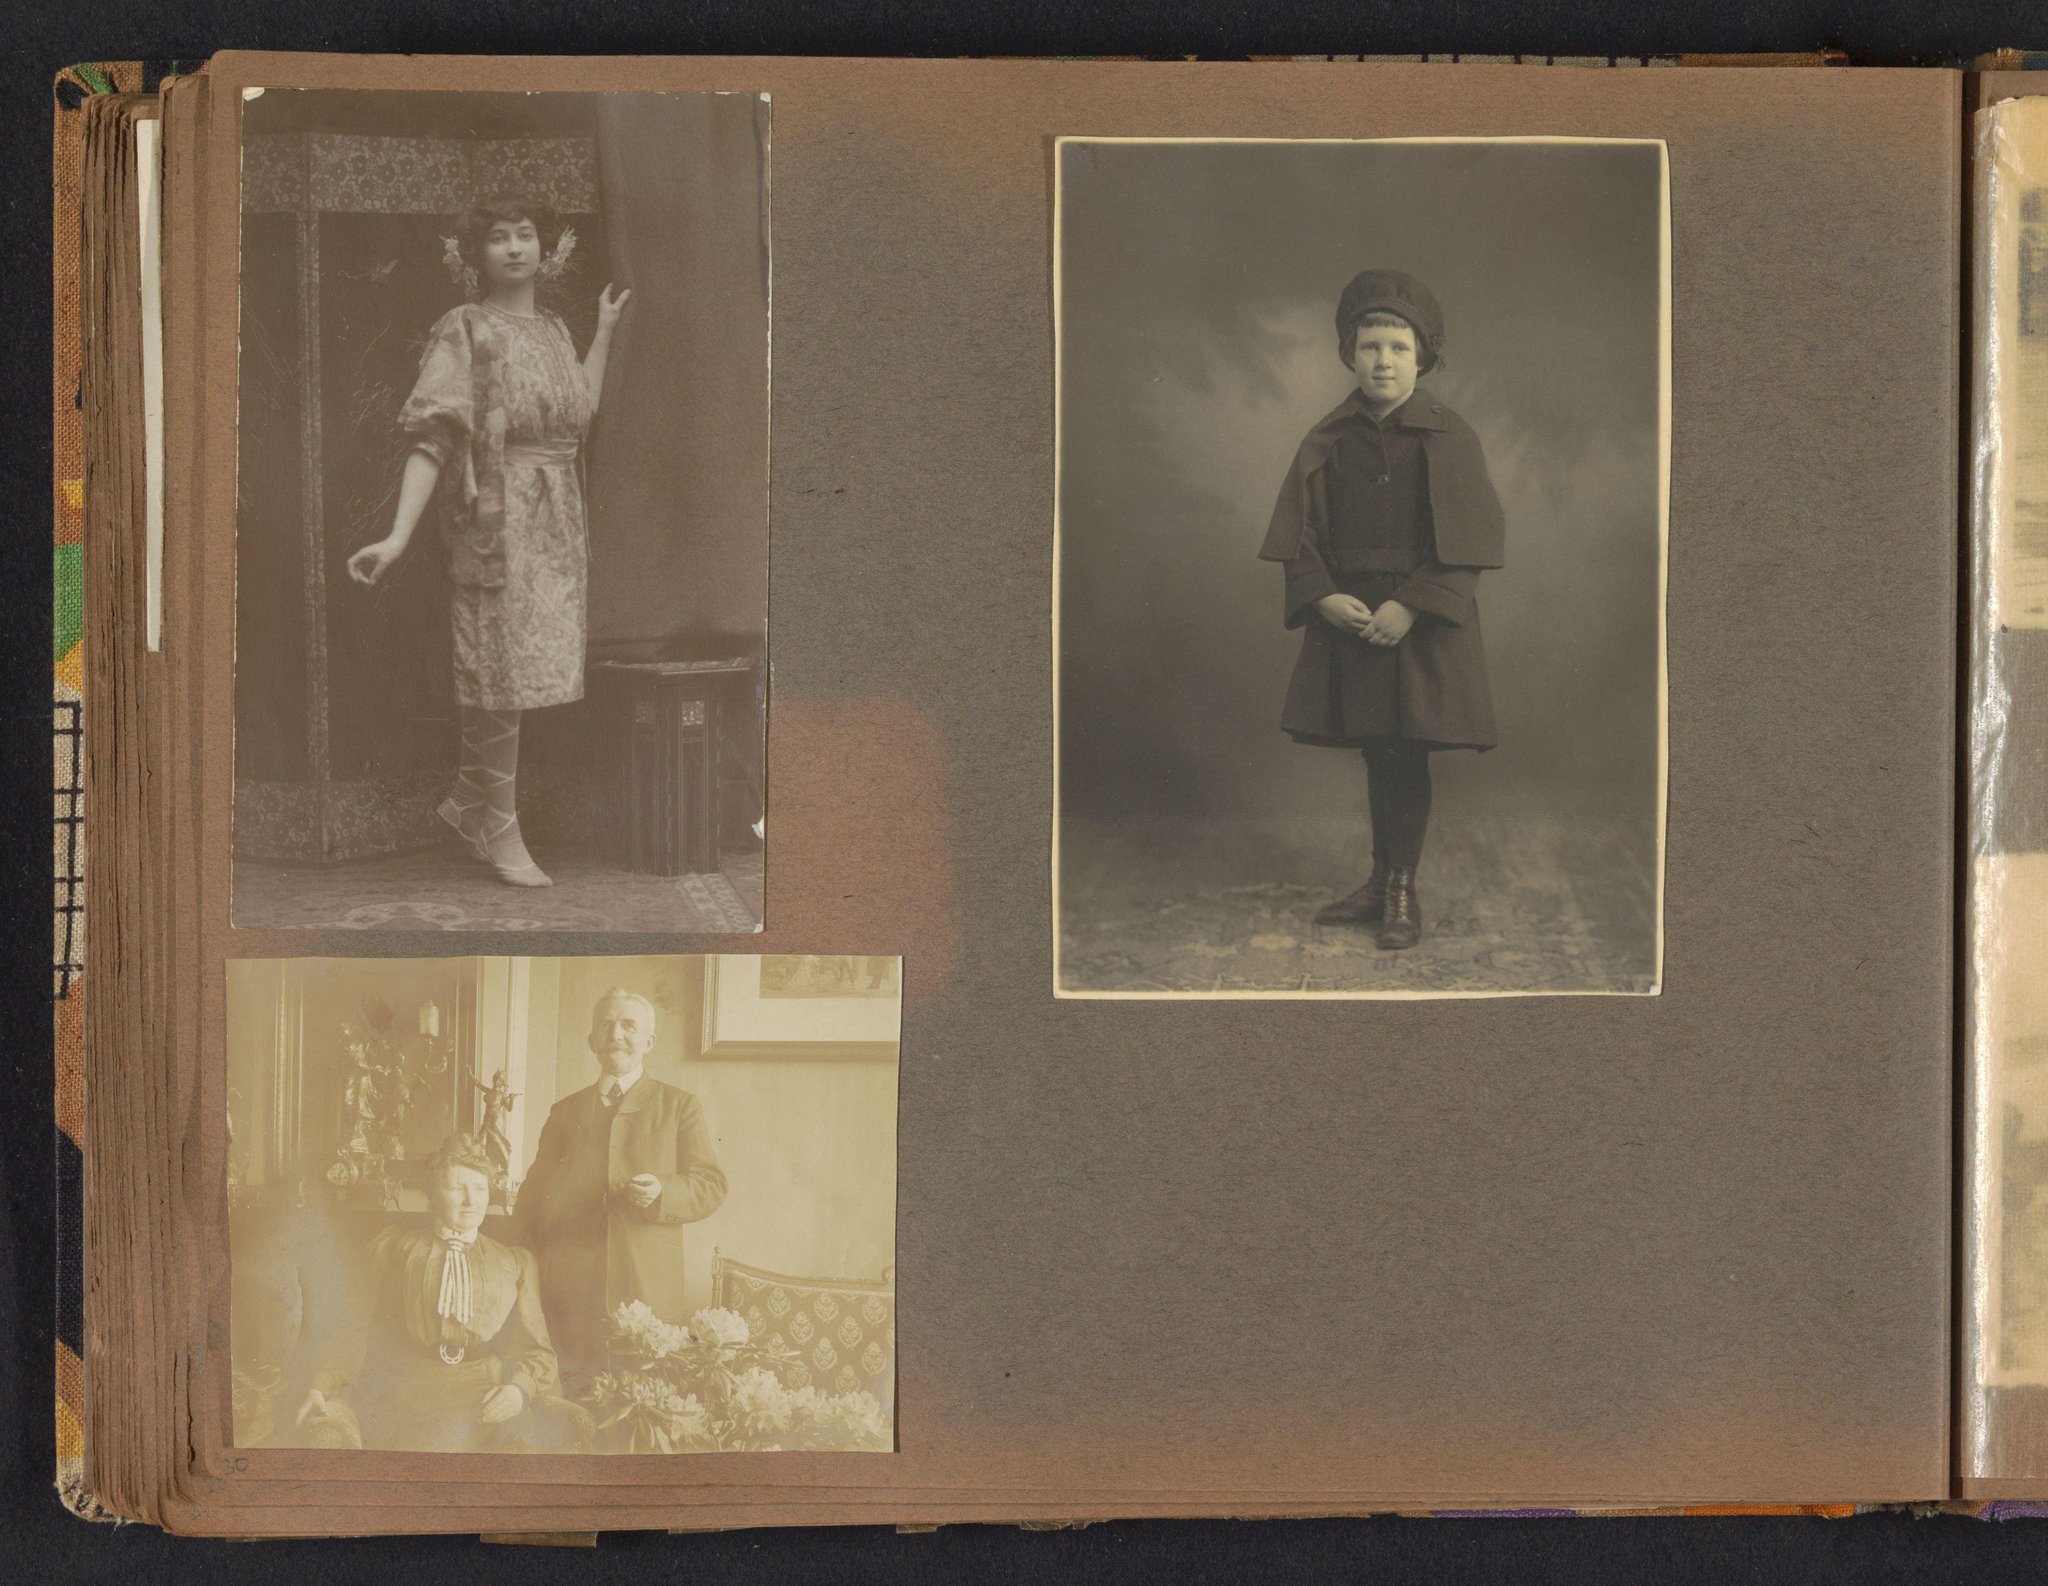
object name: photograph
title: Portretten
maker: Anonymous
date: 1900-1925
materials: cardboard, photographic support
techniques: gelatin silver print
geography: netherlands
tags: adult woman, adult man, child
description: Albumblad met portretten van een jonge vrouw, van een kind en van een echtpaar in een woonkamer. Onderdeel van Fotoalbum van een onbekende Nederlandse familie met connecties in Suriname en Nederlands-Indië (2).